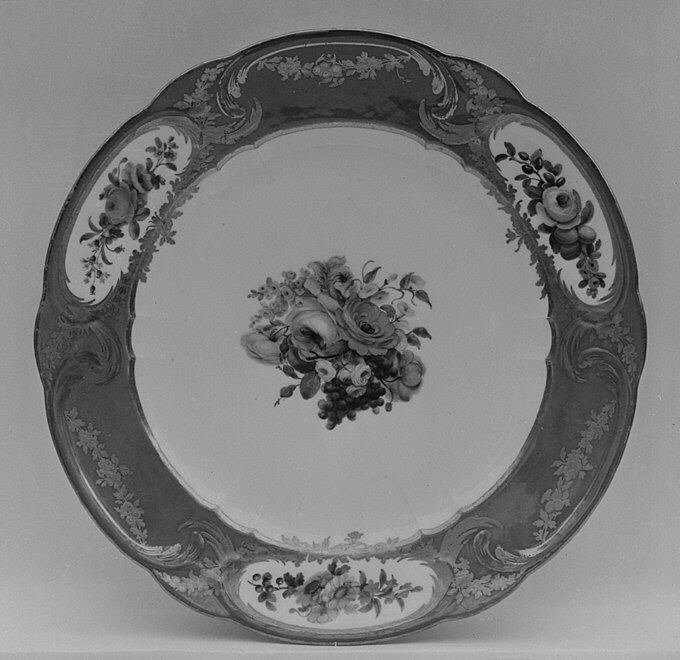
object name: plate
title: Plate (assiette à palmes) (1 of 102) (part of a service)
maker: sèvres manufactory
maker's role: manufactory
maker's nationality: french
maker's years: 1740-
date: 1786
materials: soft paste porcelain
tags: flowers